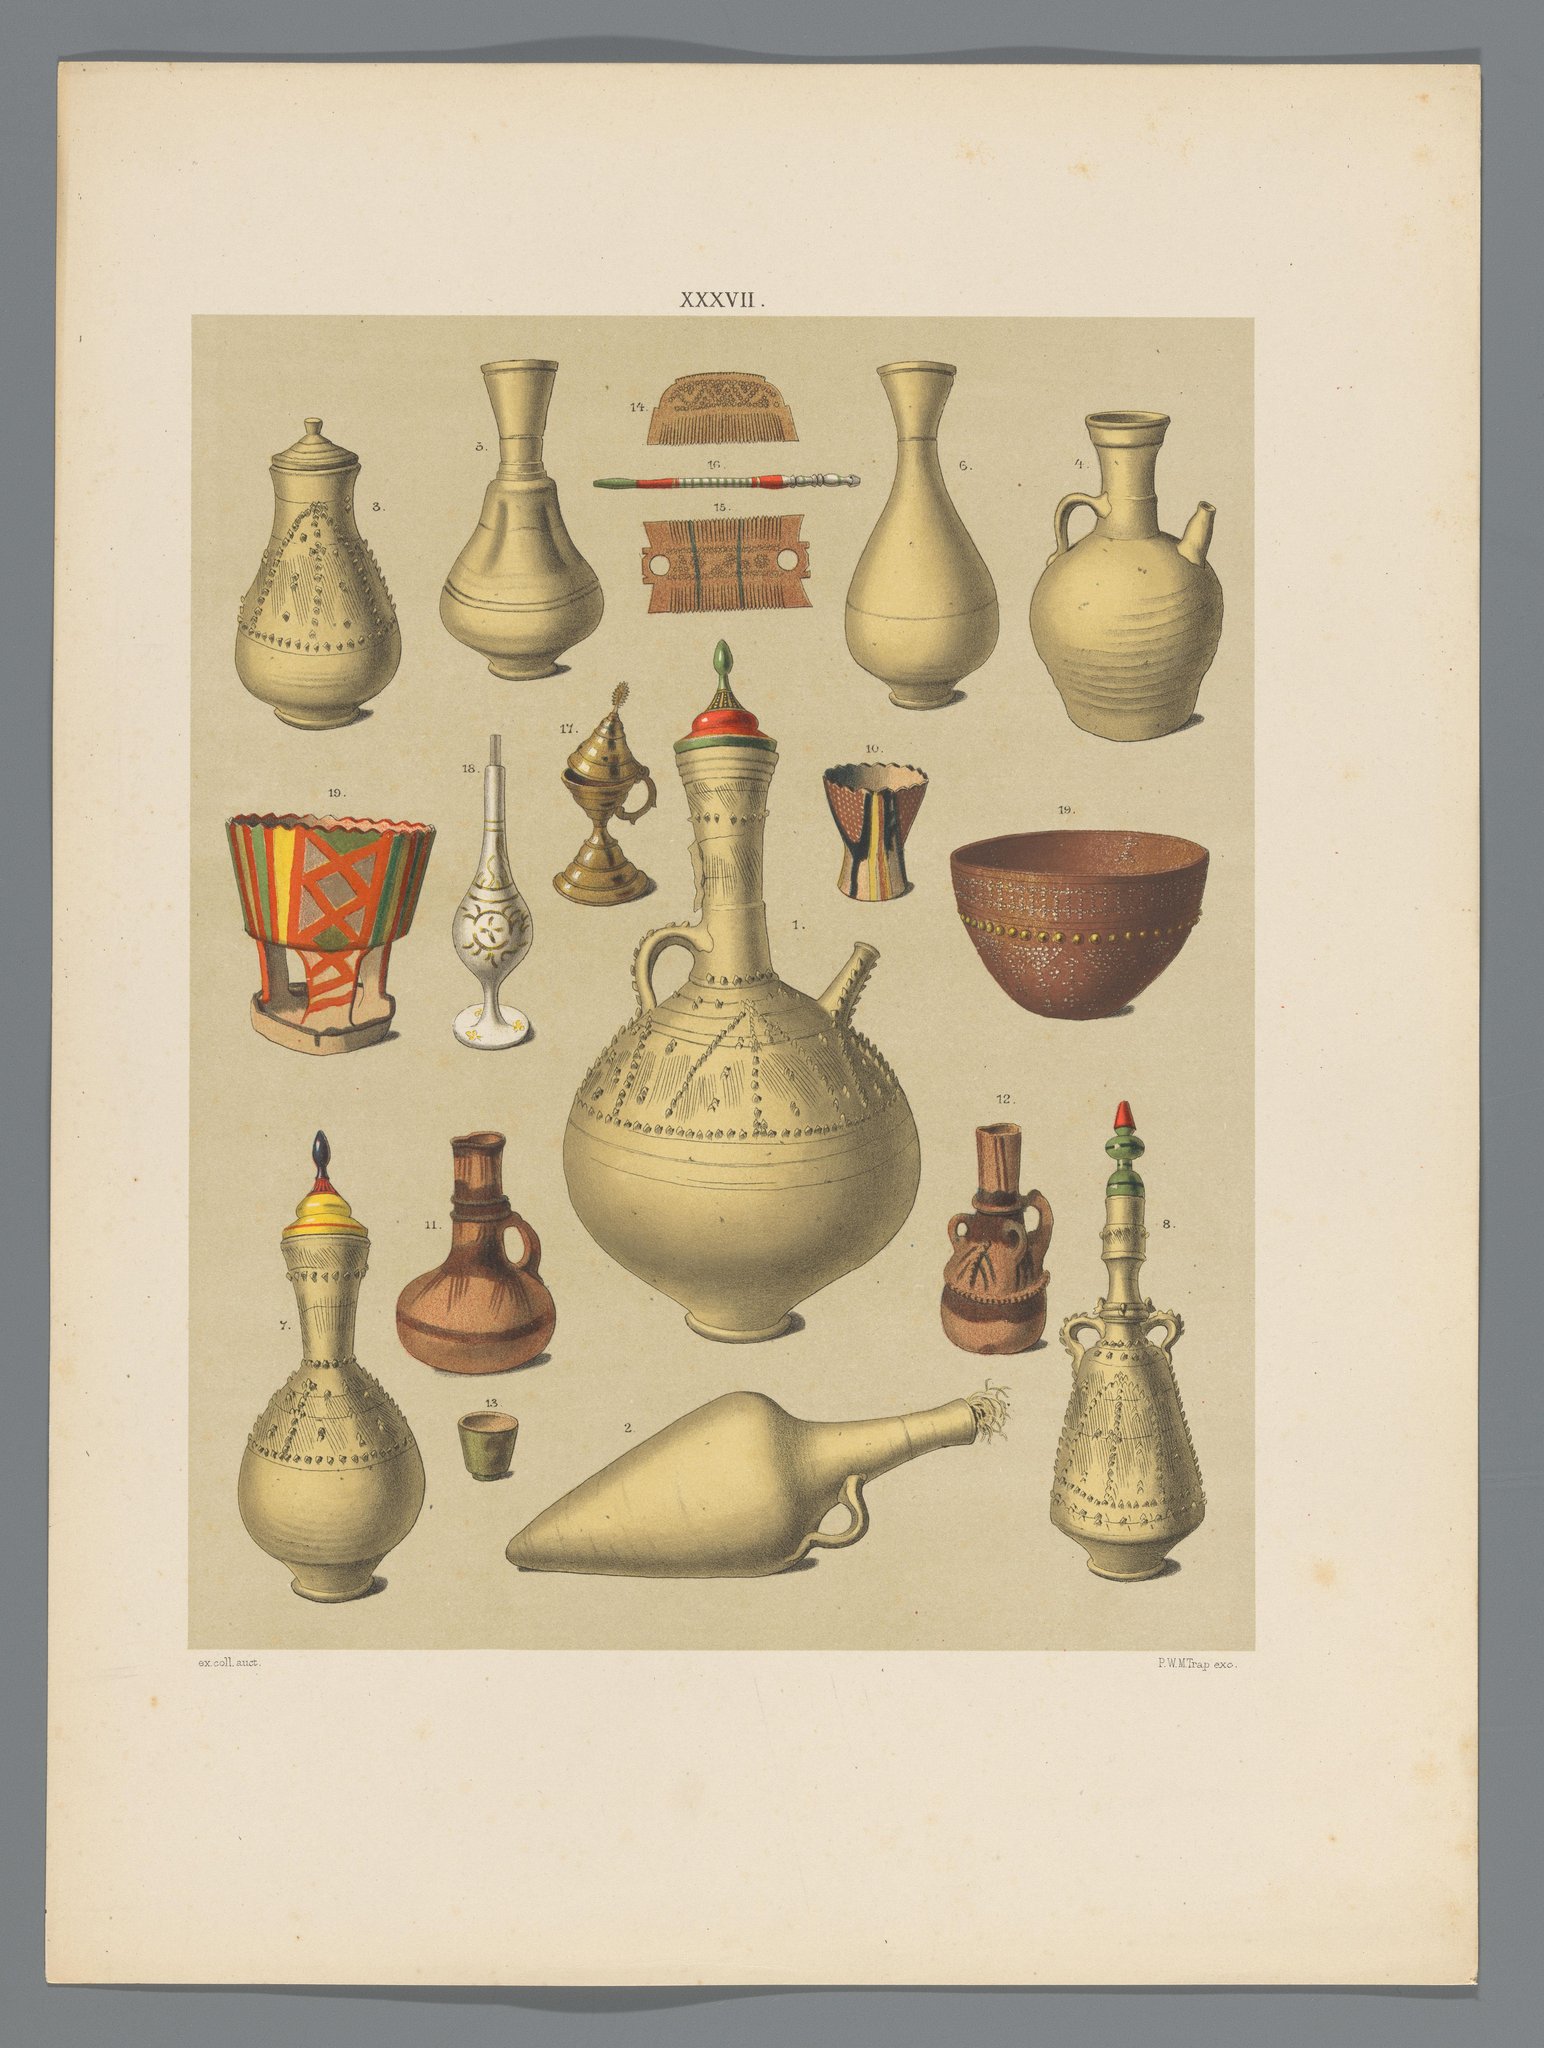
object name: print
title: Gebruiksvoorwerpen uit Mekka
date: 1883-1888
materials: paper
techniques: lithograph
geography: leiden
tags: still life of miscellaneous objects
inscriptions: number: ‘XXXVII.’